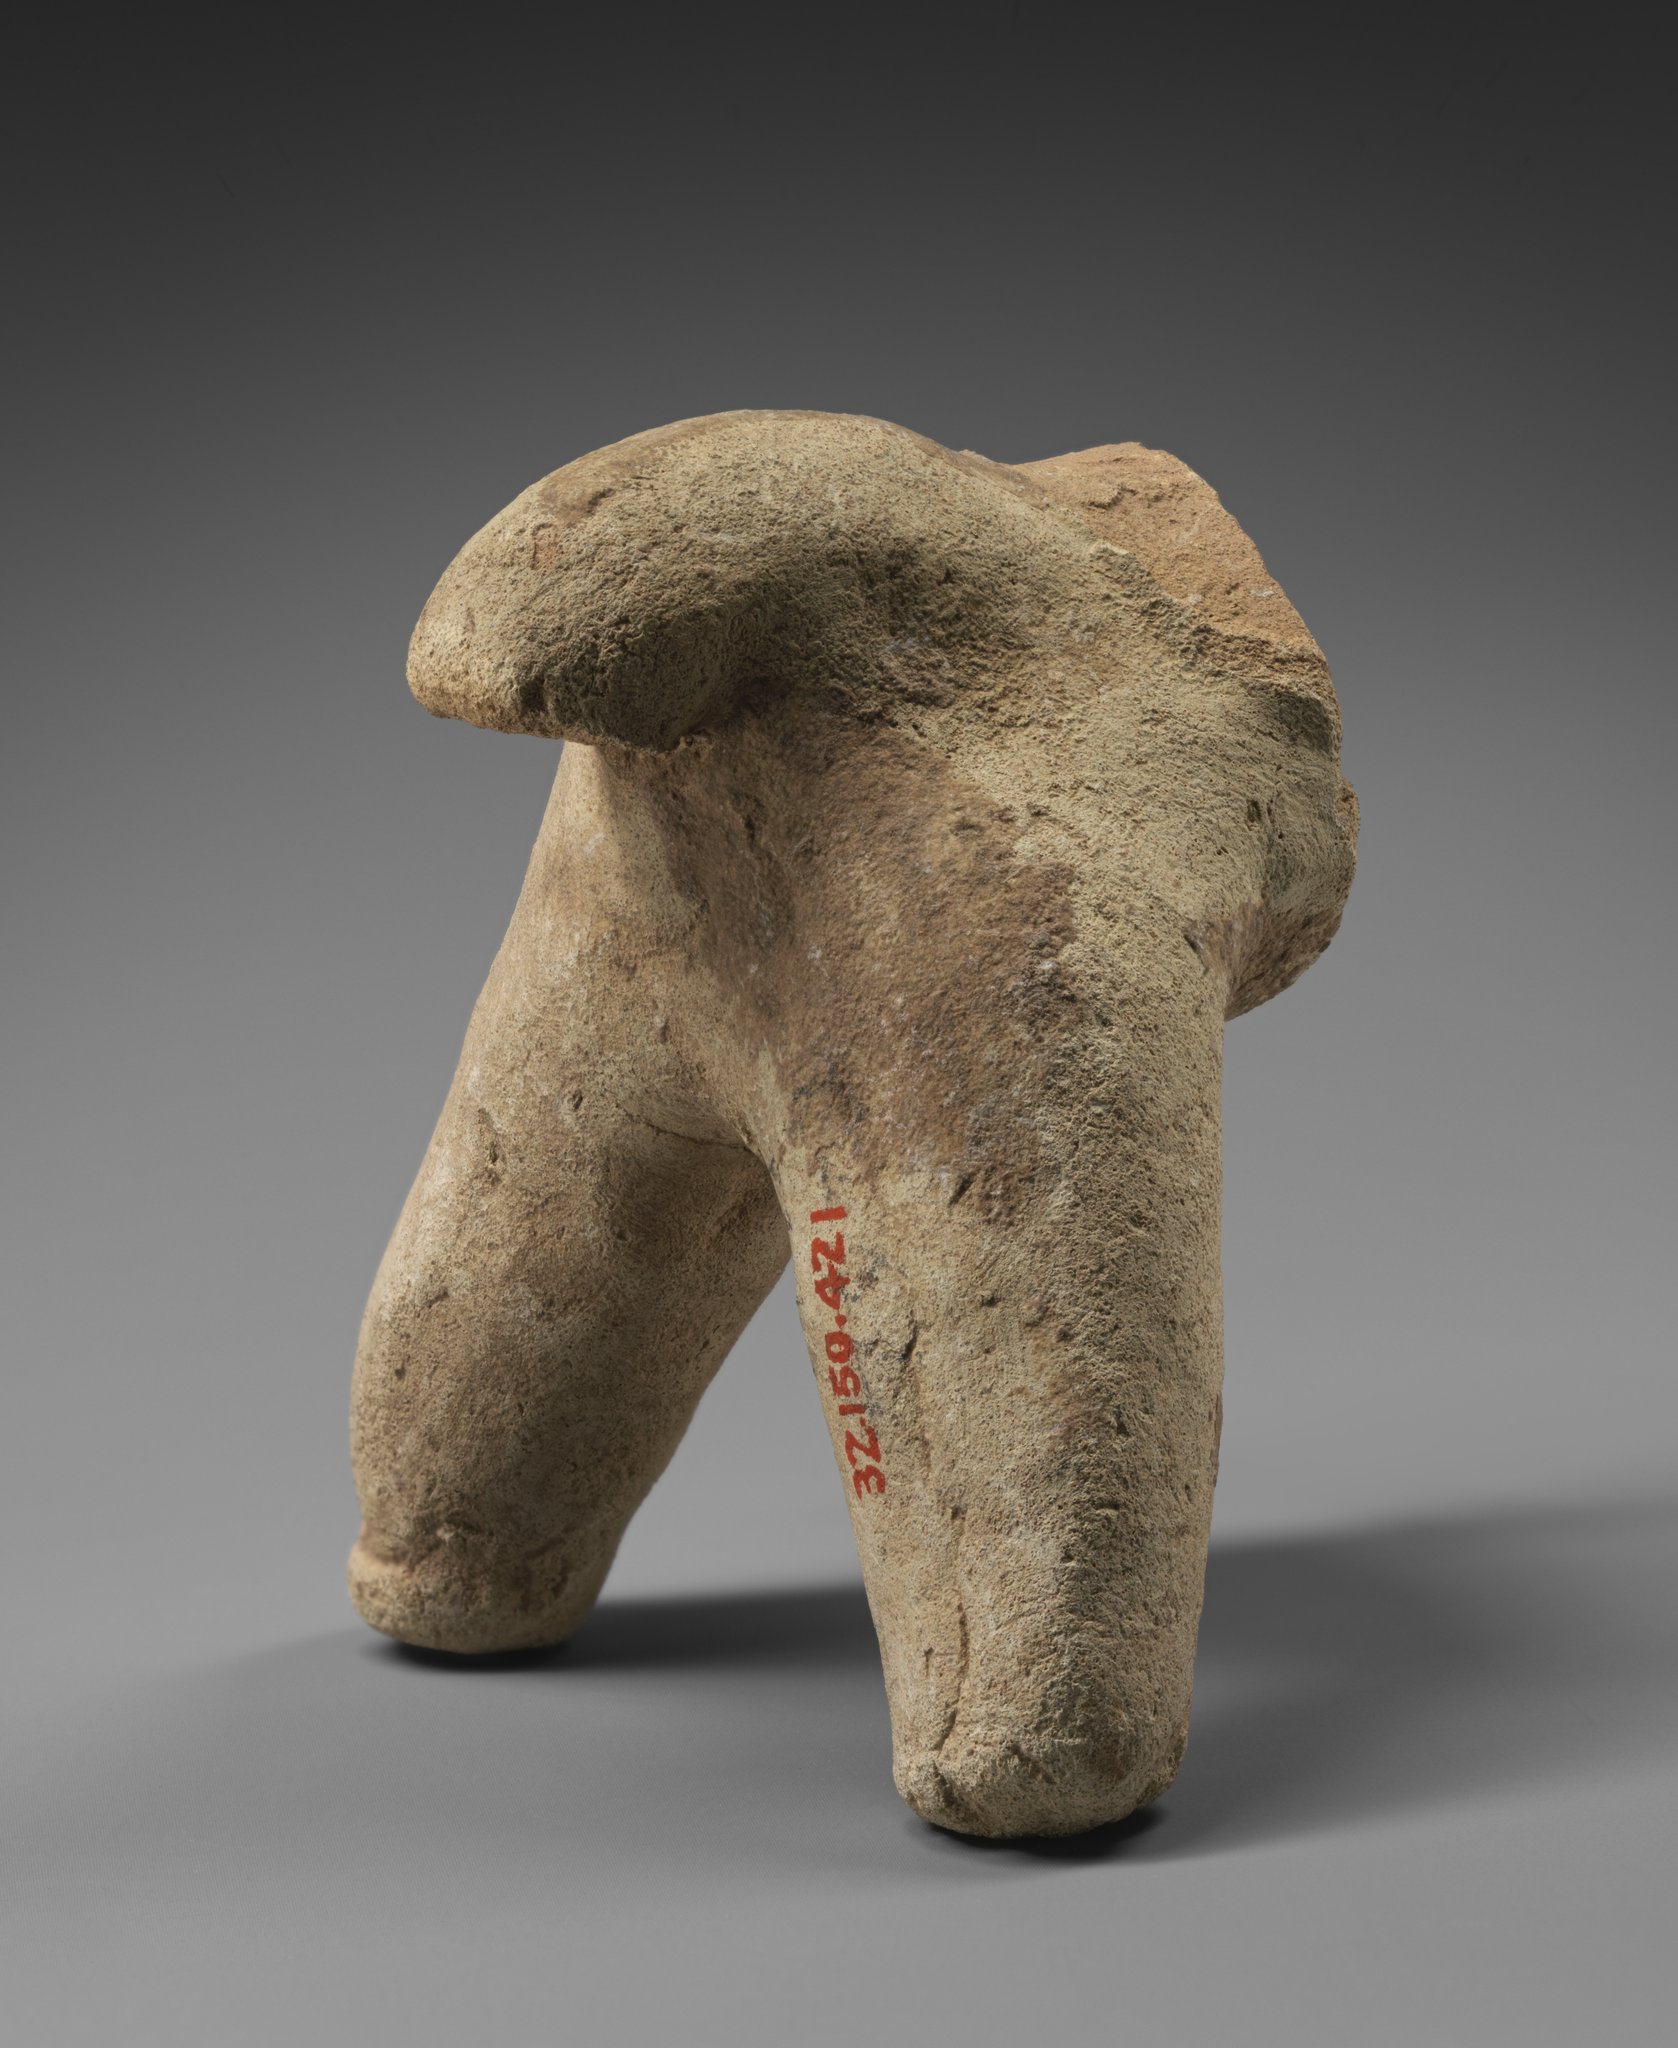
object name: sculpture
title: Animal figurine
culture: sasanian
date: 201-700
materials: ceramic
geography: mesopotamia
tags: animals